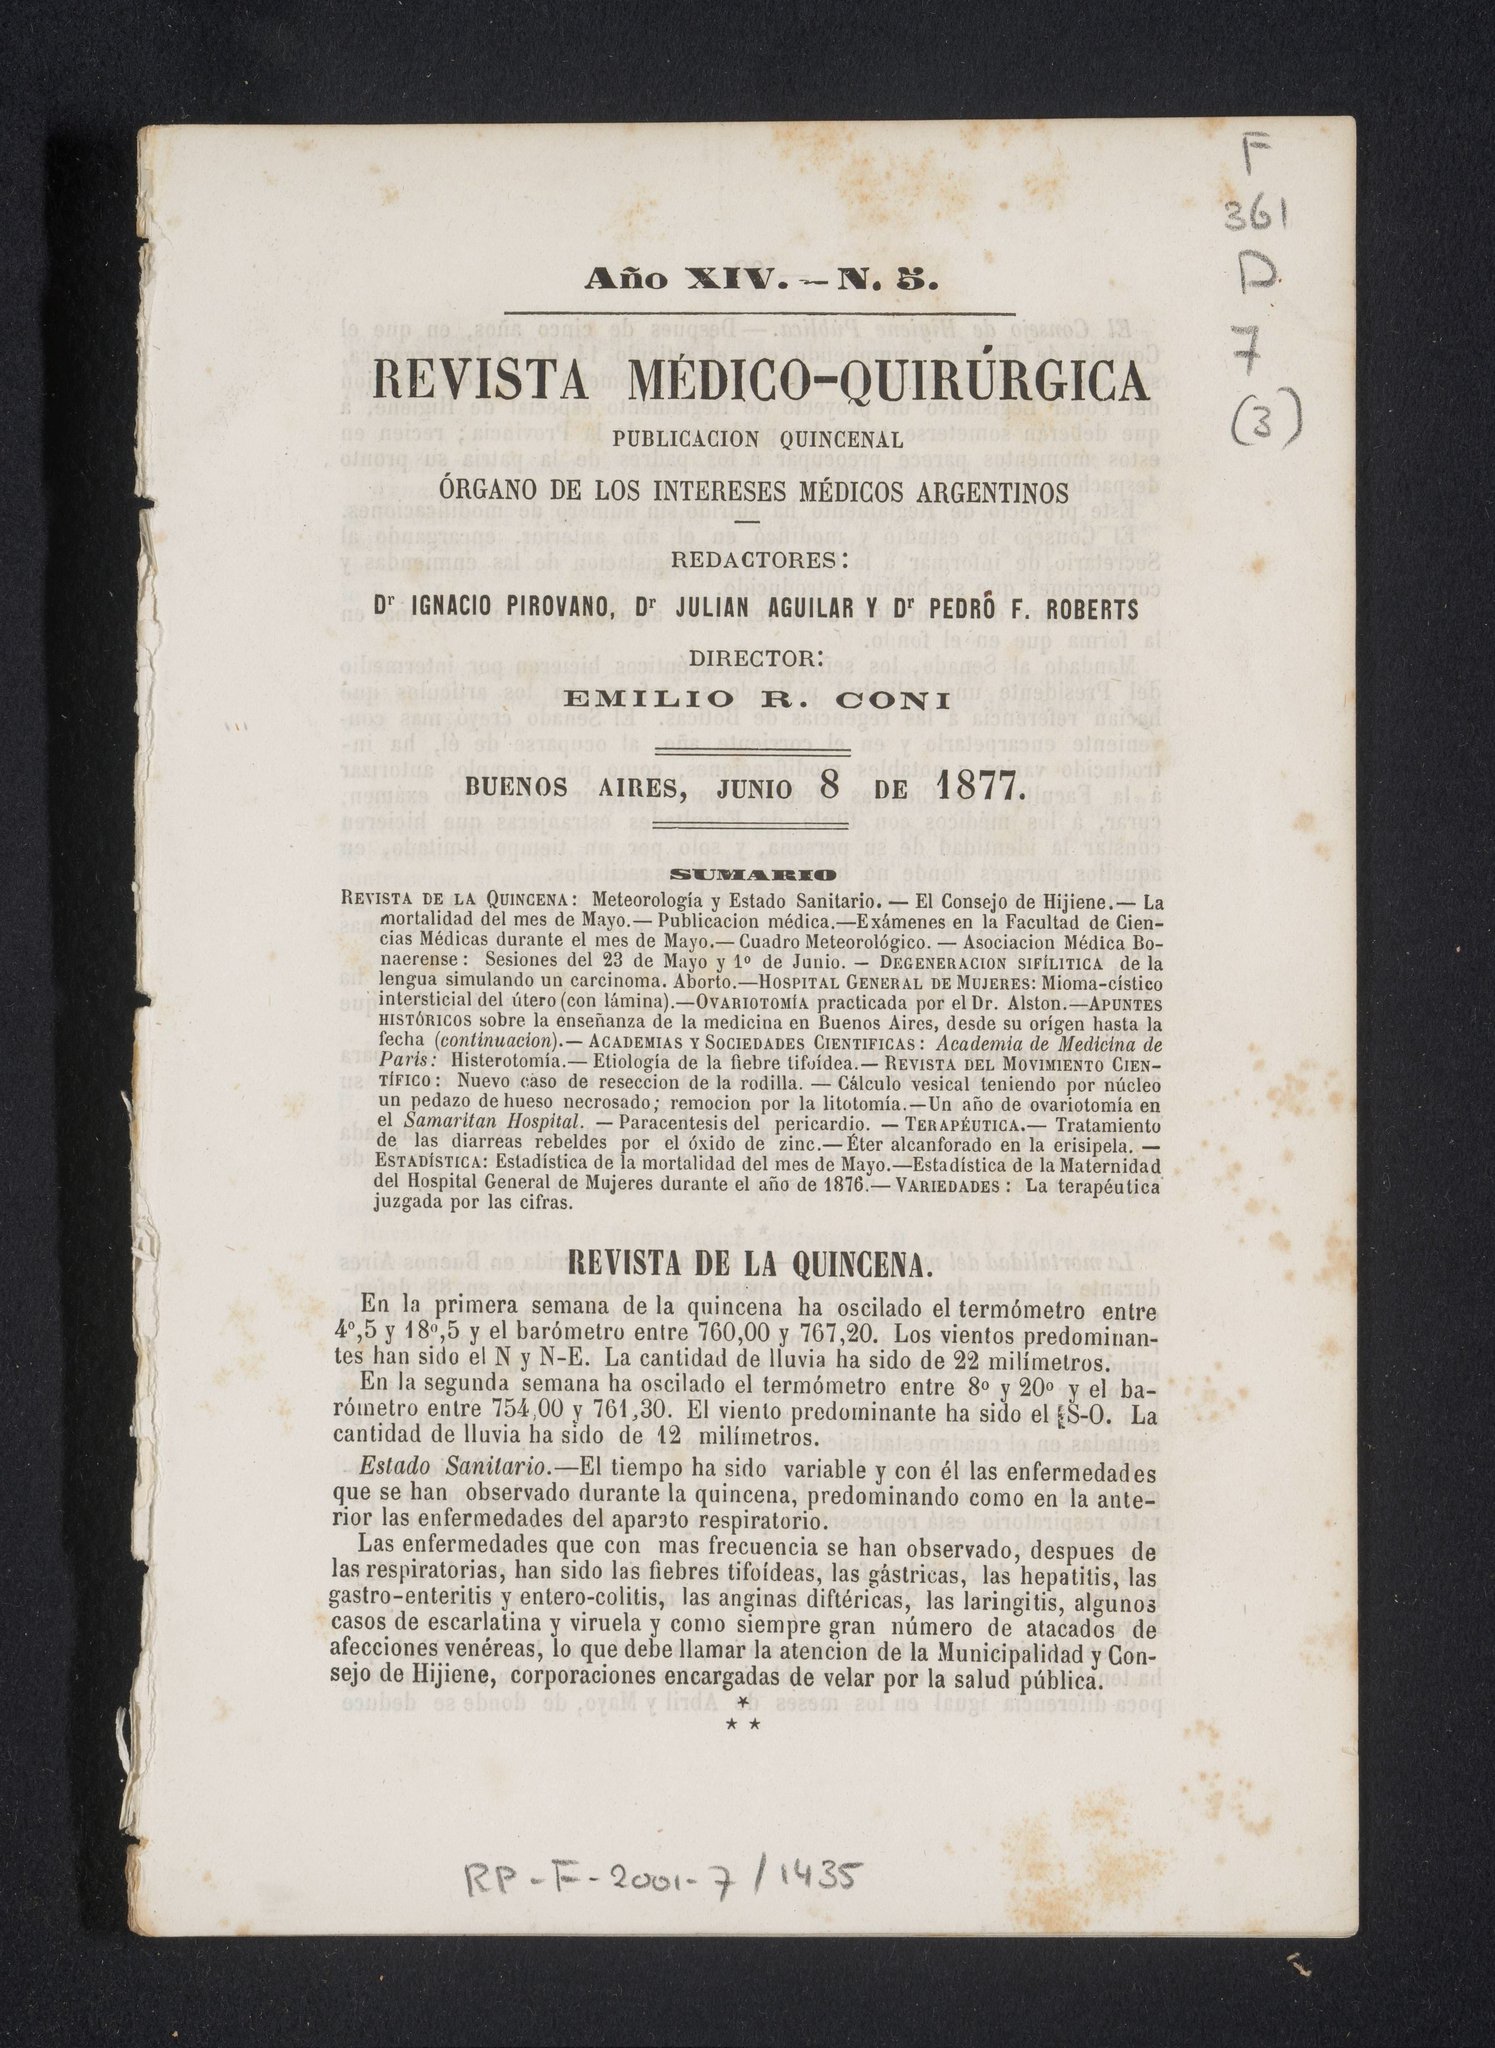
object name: magazine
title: Revista médico-quirúrgica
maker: emilio r. coni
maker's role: arts, voorzitter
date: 1877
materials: paper, photographic support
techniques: albumen print, printing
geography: buenos aires